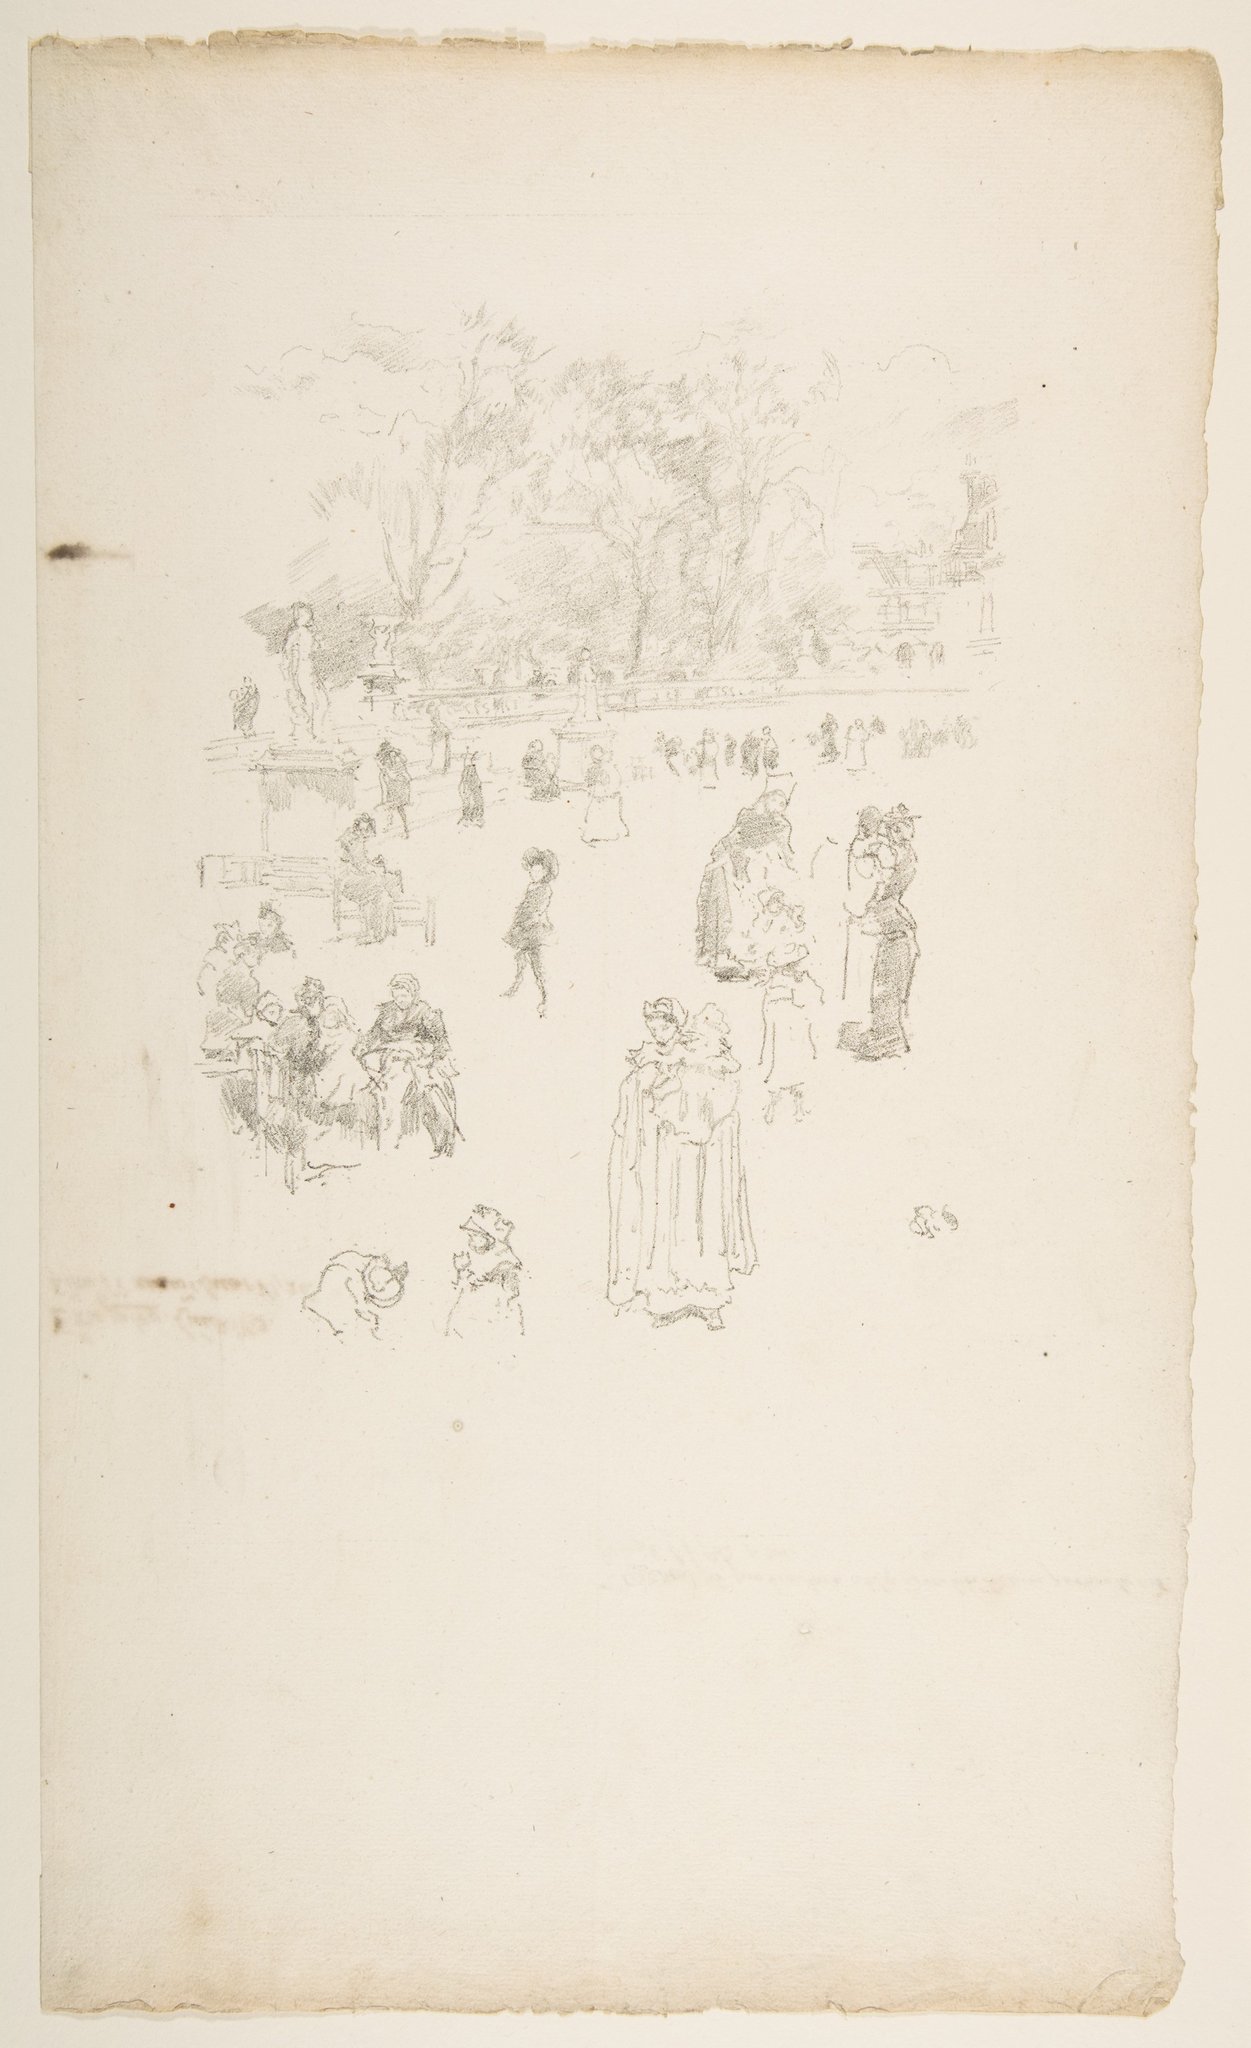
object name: print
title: Nursemaids: "Les Bonnes du Luxembourg"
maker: james mcneill whistler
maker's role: artist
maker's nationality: american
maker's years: 1834-1903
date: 1894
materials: ink, paper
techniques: printing, lithography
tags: gardens,children,men,women